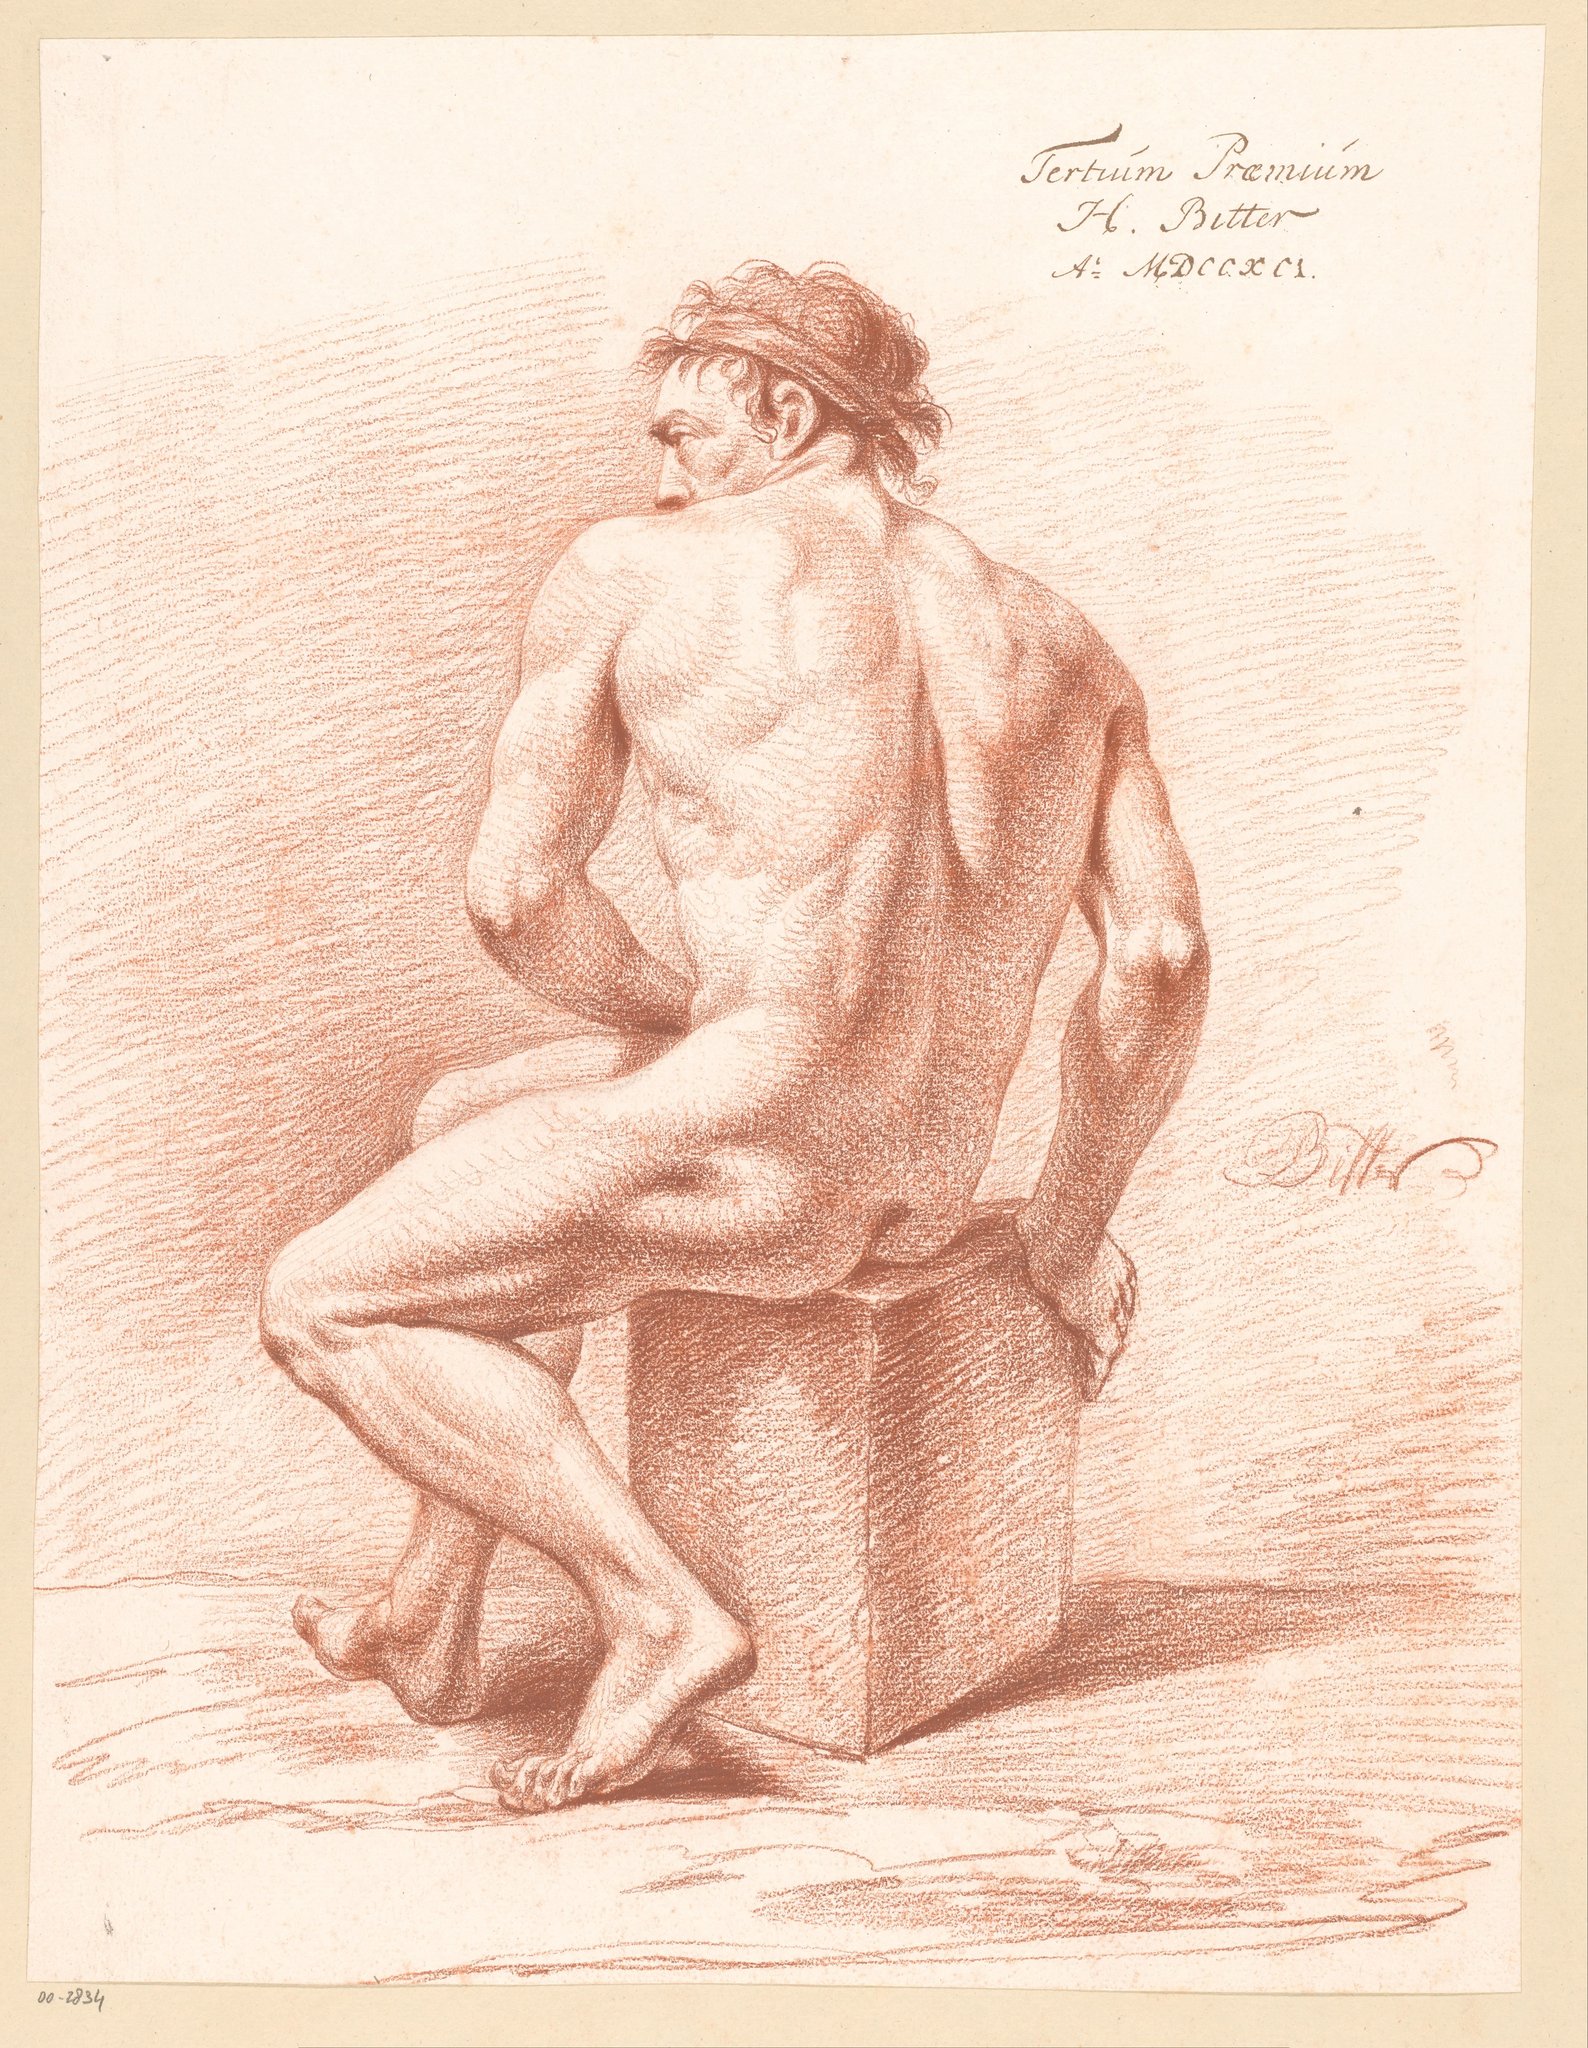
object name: drawing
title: Zittend mannelijk naakt, op de rug gezien (3e prijs 1791)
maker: hendrik bitter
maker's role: draughtsman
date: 1791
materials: chalk, charcoal, paper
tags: sitting figure (+ nude human being)